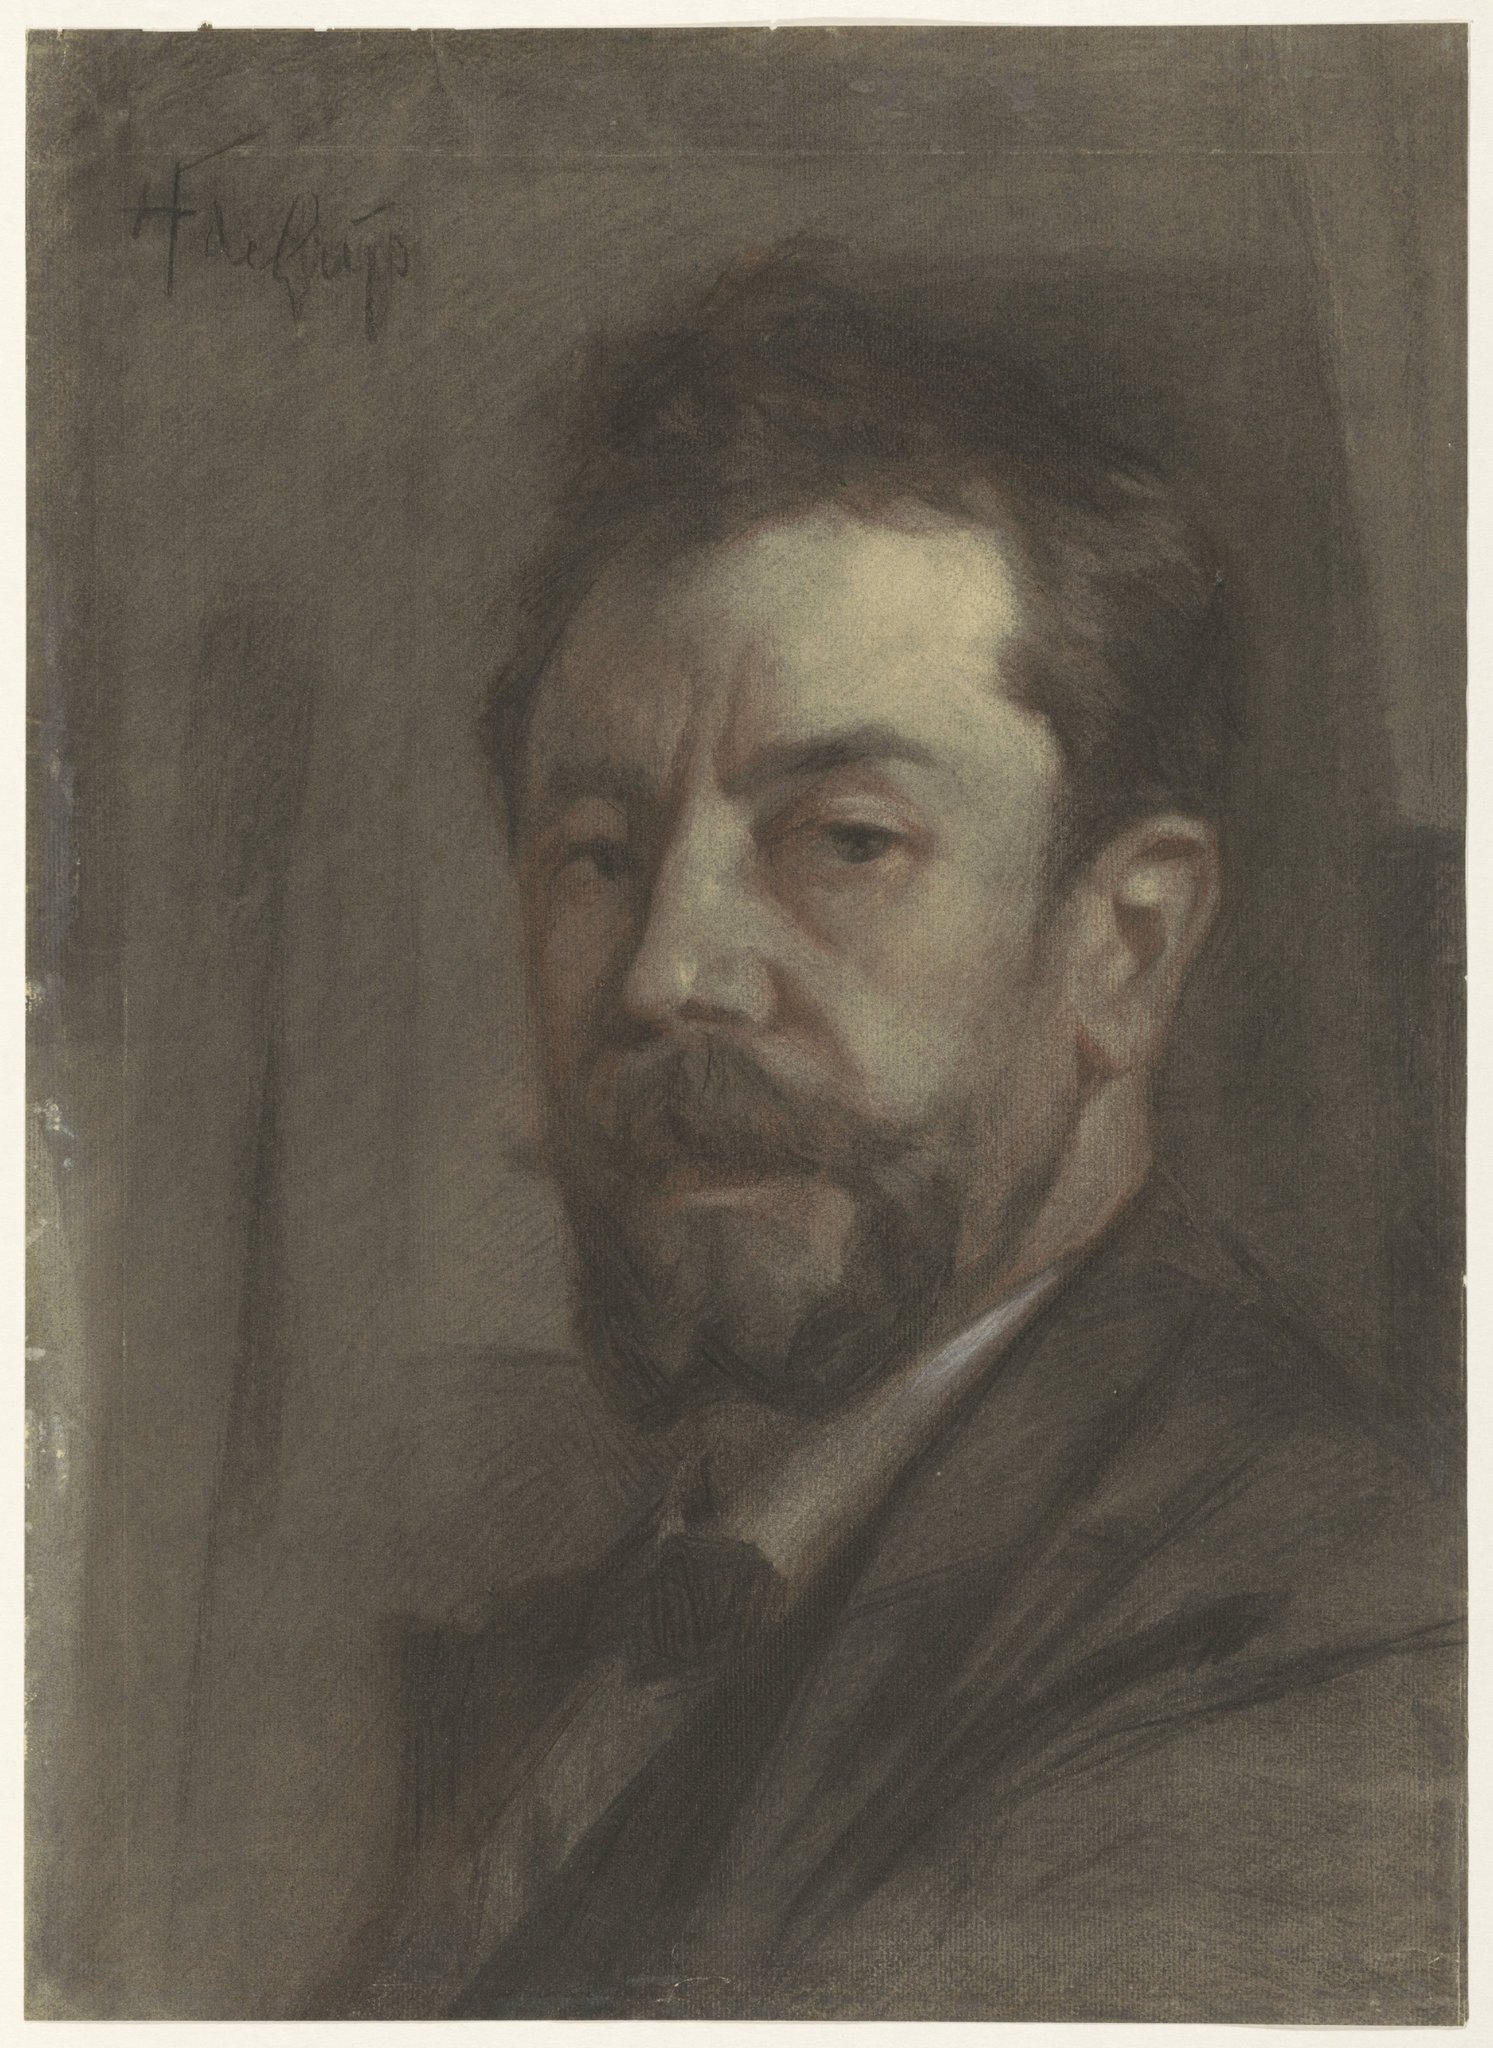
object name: drawing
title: Portret van de schilder Hendrikus Fredericus de Grijs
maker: hendrikus fredericus de grijs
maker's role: painter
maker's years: 1866-1933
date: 1876-1933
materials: chalk, paper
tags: hendrikus fredericus de grijs, historical persons, portrait, self-portrait of artist, portrait, self-portrait of draughtsman